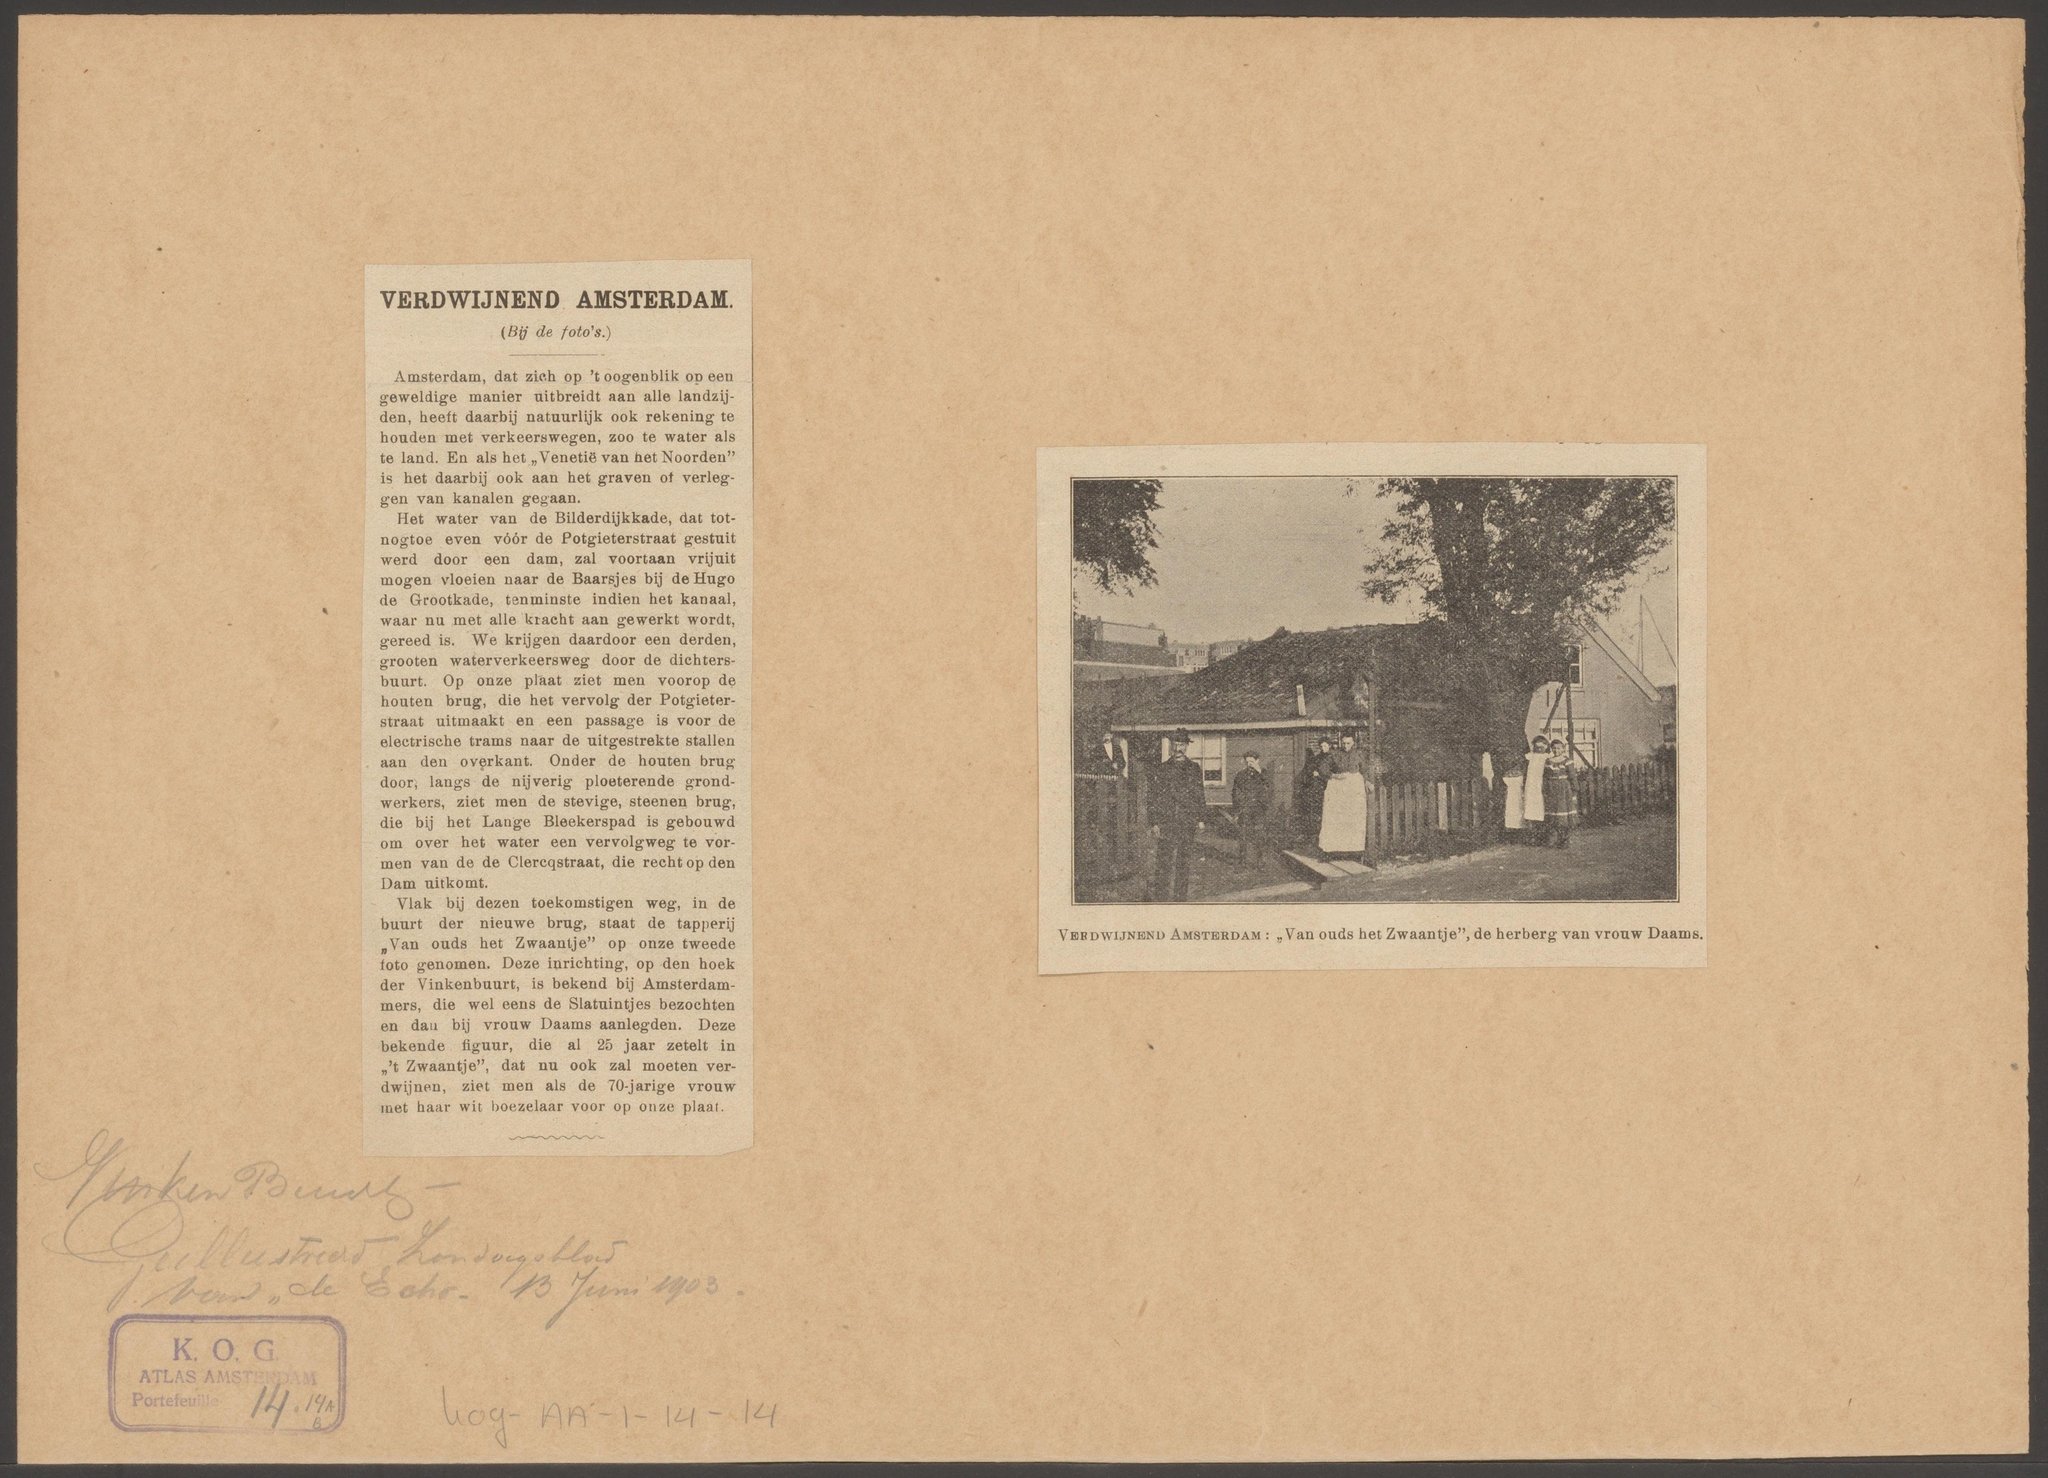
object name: photomechanical print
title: Gezicht op de herberg Het Zwaantje in de Vinkenbuurt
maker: Anonymous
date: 1903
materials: paper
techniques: letterpress printing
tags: city-view in general; 'veduta', road, path, hotel, hostelry, inn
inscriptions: collector's mark: ‘14.14A / B’ Lugt 1641b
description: Onderwerpsrubriek binnen de Atlas Amsterdam: Verhulststraat (Johannes), Viaducten, Vierwindenstraat, Vinkenbuurt, Vinkenpad, Vinkenstraat, Vischsteeg, Vliegendesteeg, Voetboogstraat, Volewijk, Vondelstraat, Voorburgwal (N.Z.).